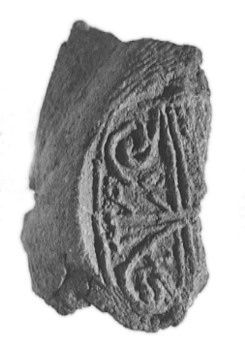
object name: sealing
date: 2030-1640 BCE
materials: clay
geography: egypt